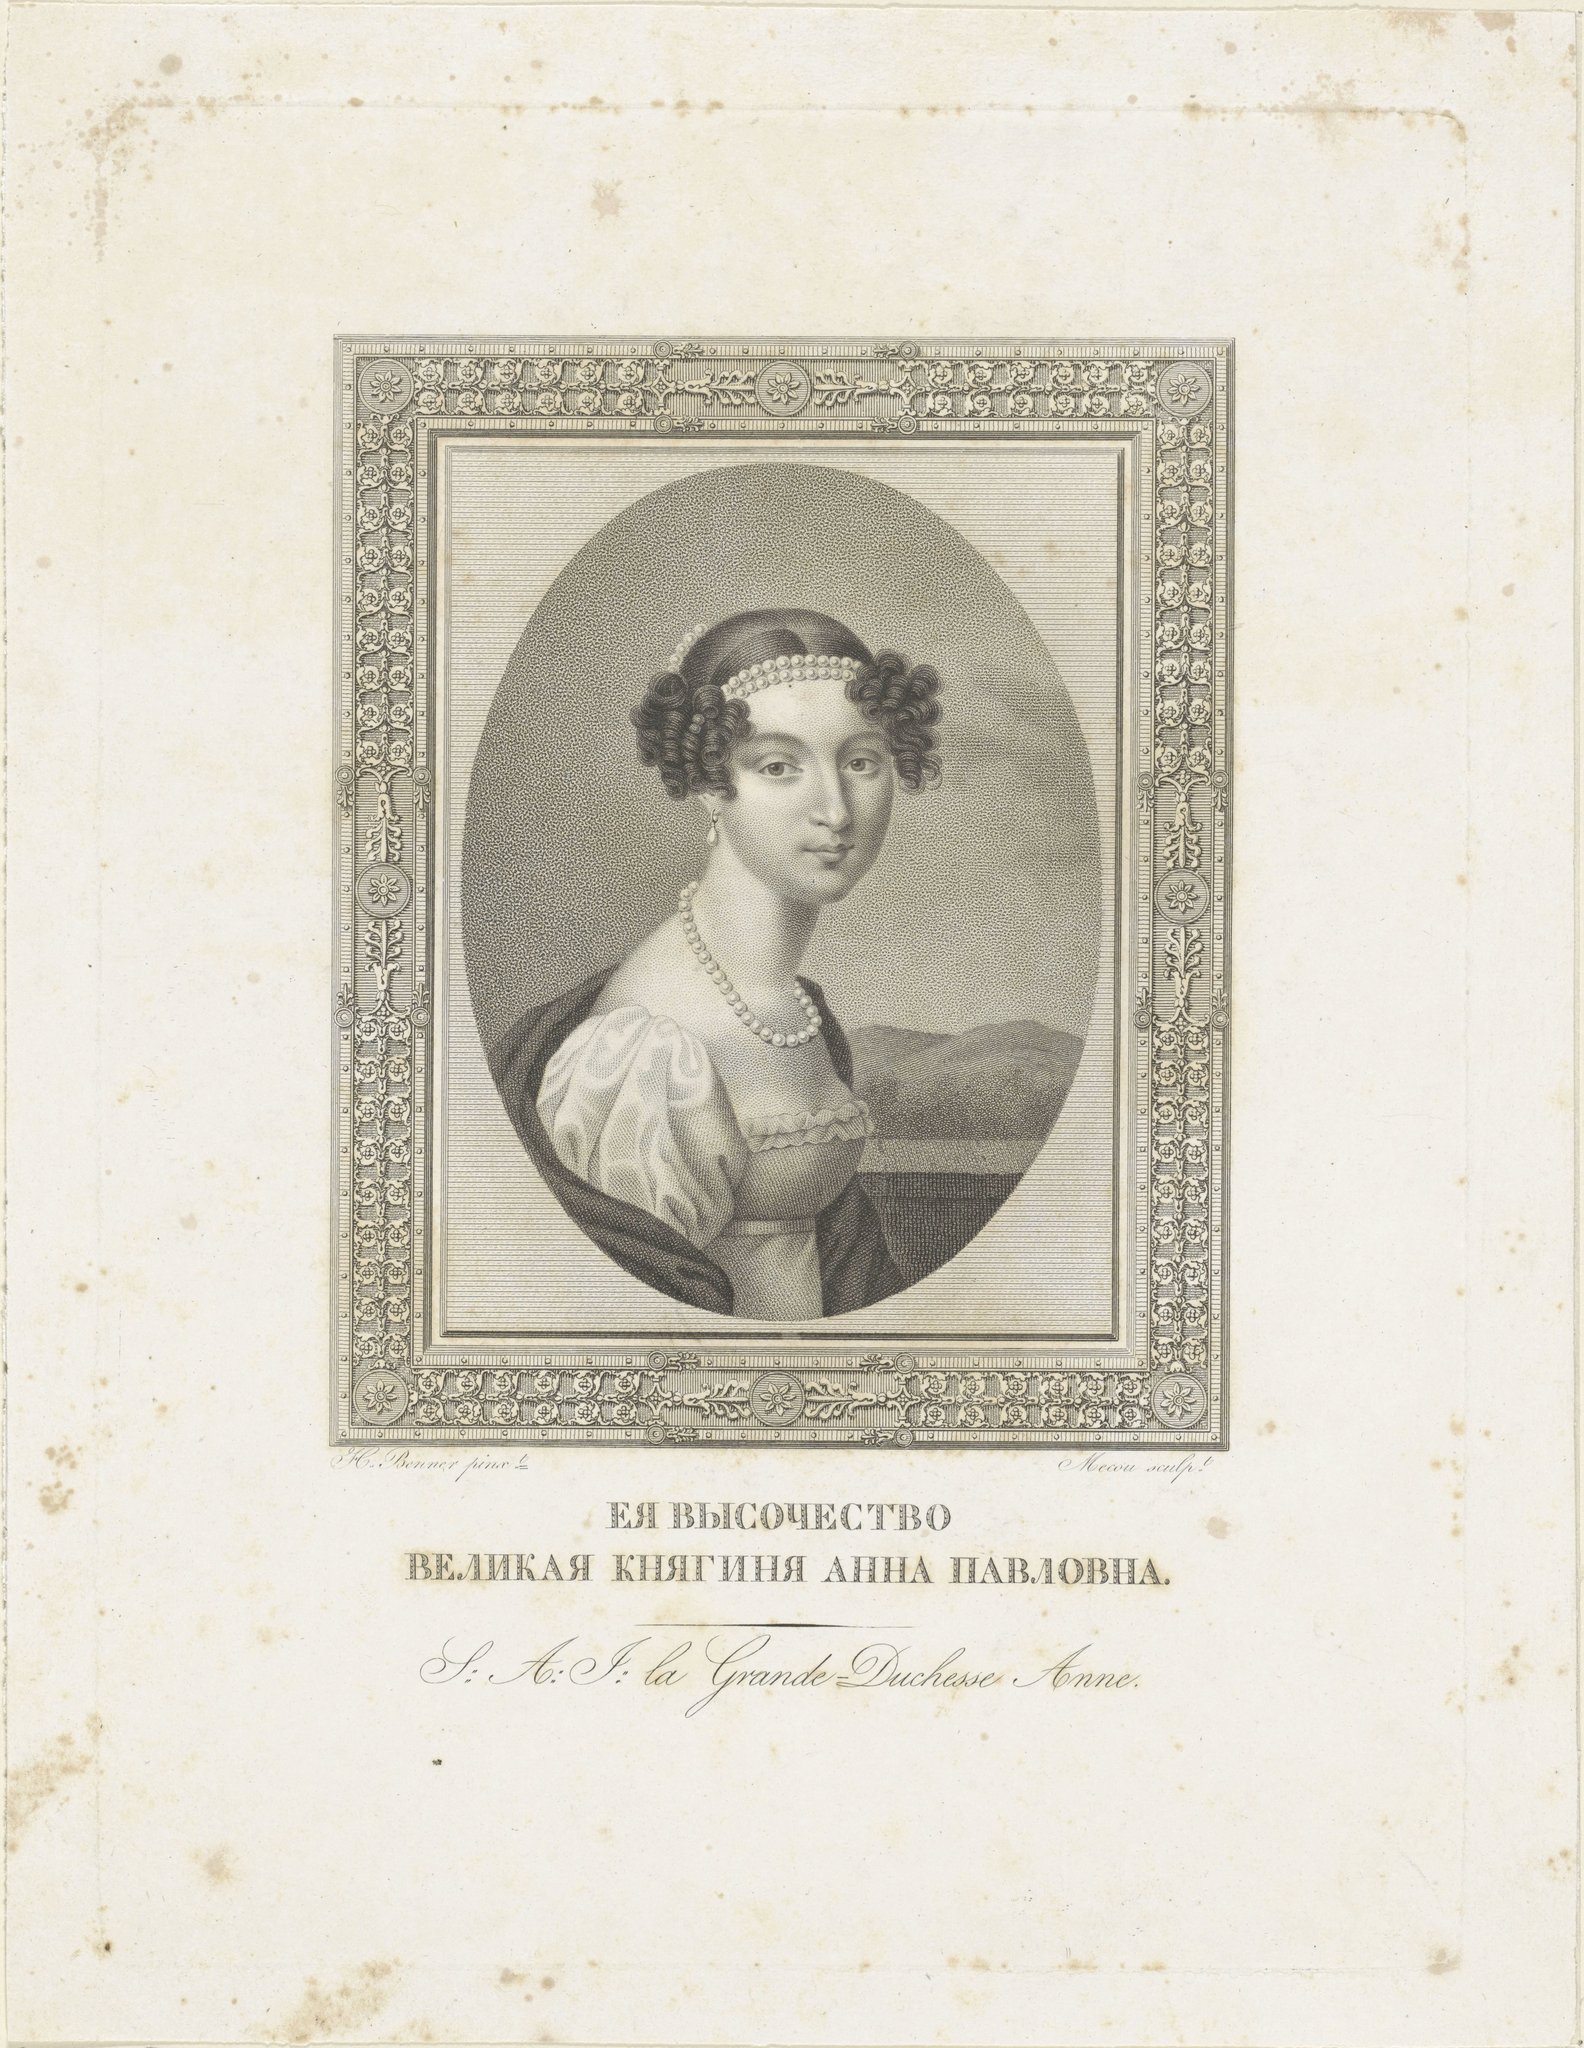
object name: print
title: Portret van Anna Paulowna Romanowa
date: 1810-1899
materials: paper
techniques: engraving, etching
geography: france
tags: the hague, anna paulowna romanowa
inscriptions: collector's mark: Lugt 2228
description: Portret van Anna Paulowna in een geornamenteerde rechthoek. In de ondermarge twee regels Russische tekst en een regel Franse tekst.